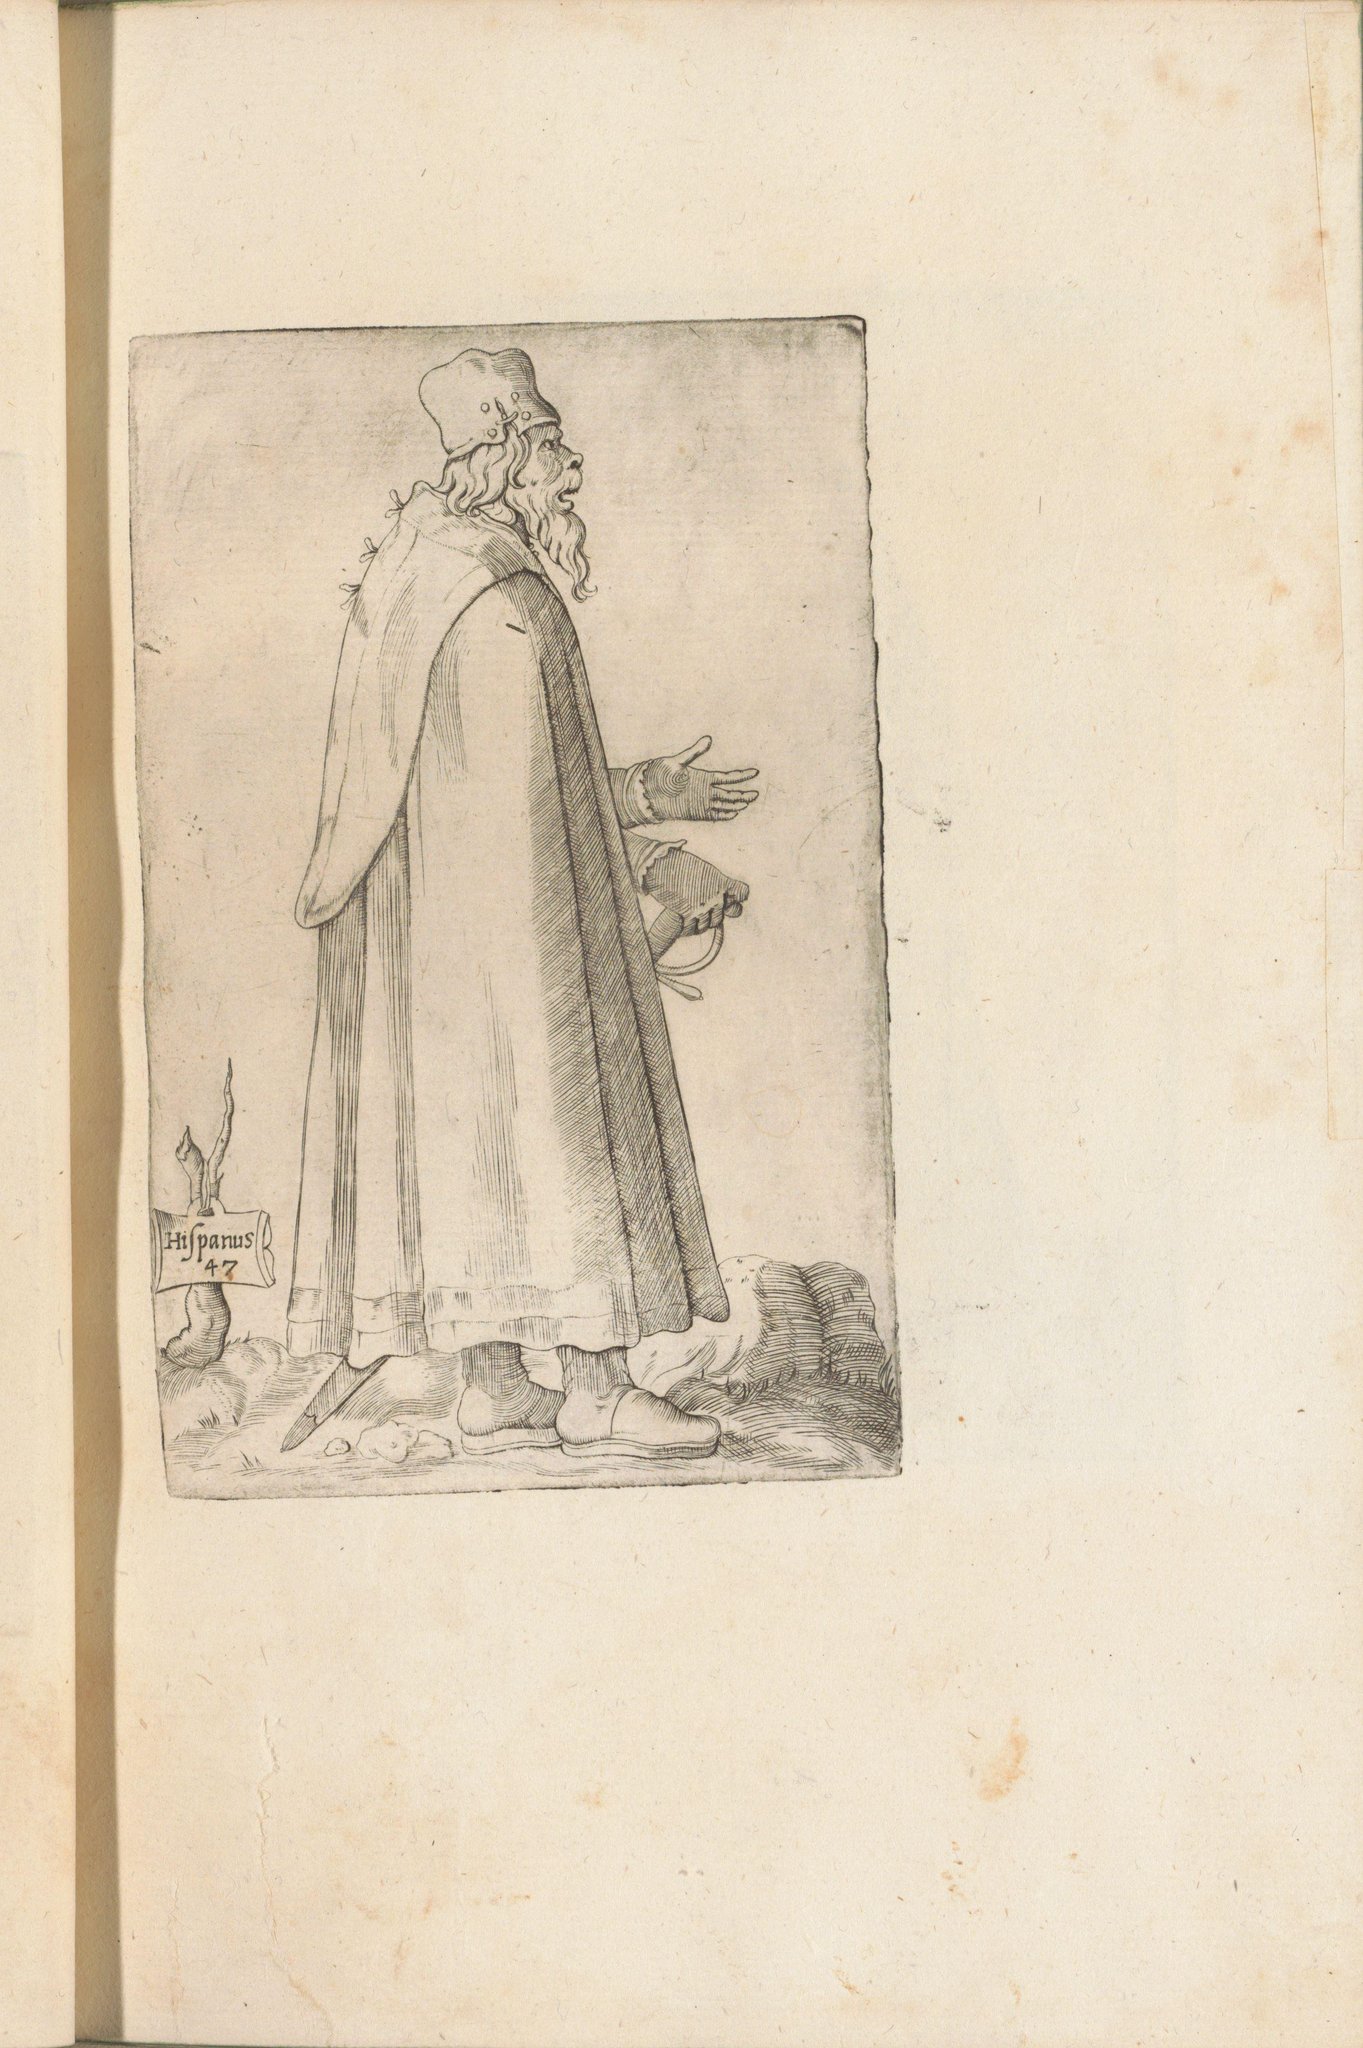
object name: costume print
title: Omnium fere gentium nostrae aetatis habitus, nunquam ante hac aediti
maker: ferando bertelli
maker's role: print maker, publisher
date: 1569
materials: paper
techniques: engraving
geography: venice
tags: europeans: spaniards (+ costume), cape (+ men's clothes), clothes, costume (+ men's clothes), spain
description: Spaanse man met lange baard, in wijde mantel, mutsje op het hoofd, naar rechts. Onderdeel van het kostuumboek getiteld 'Omnium fere gentium nostrae aetatis habitus, nunquam ante hac aediti', Venetië 1569. Heruitgave uit 1569 van de eerste editie uit 1563.